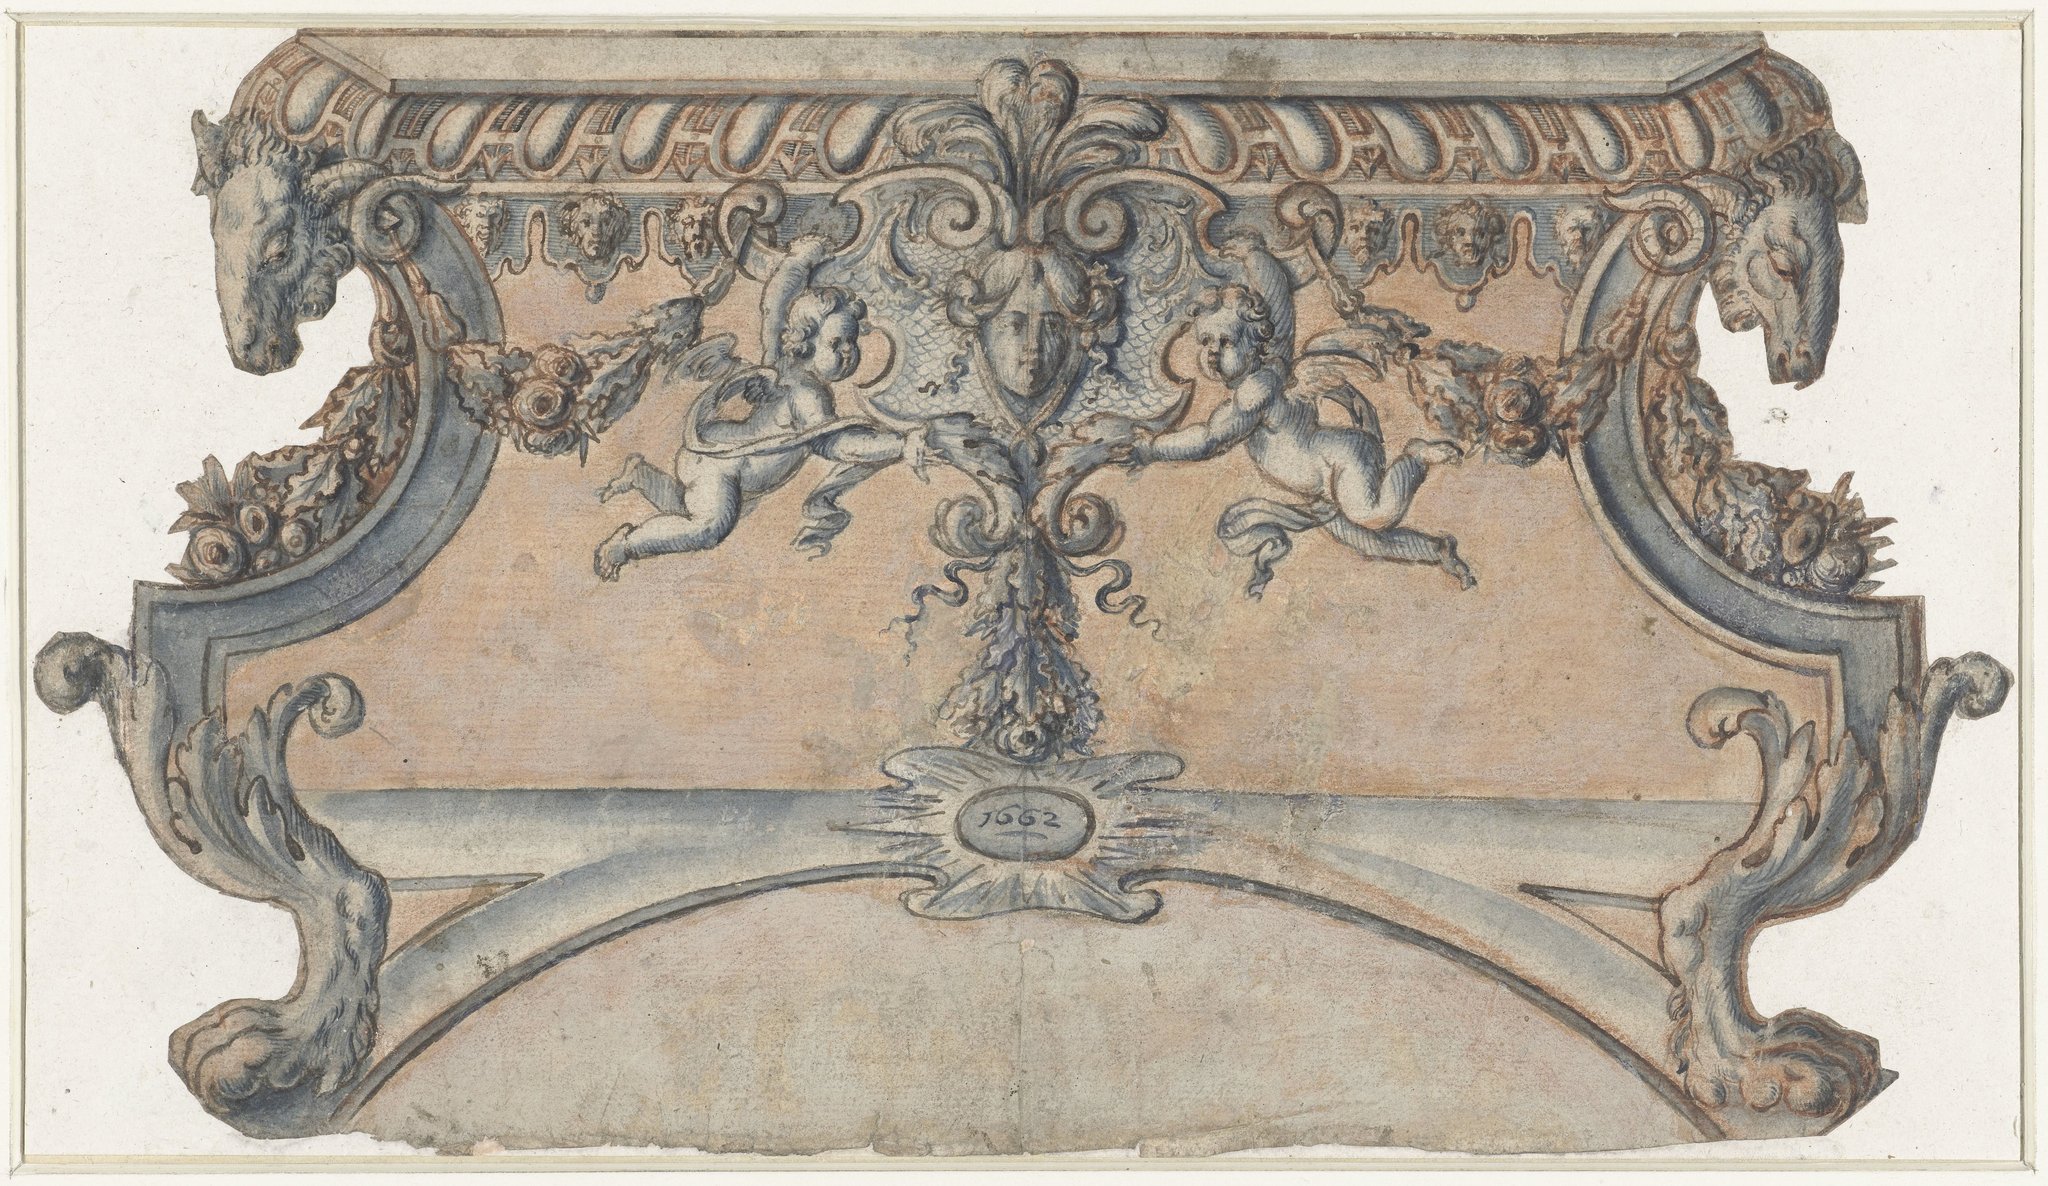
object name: design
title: Ontwerp voor een Lodewijk XIV-penanttafel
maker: Anonymous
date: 1662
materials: chalk, ink, paper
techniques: brush, pen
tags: table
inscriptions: date: ‘1662’